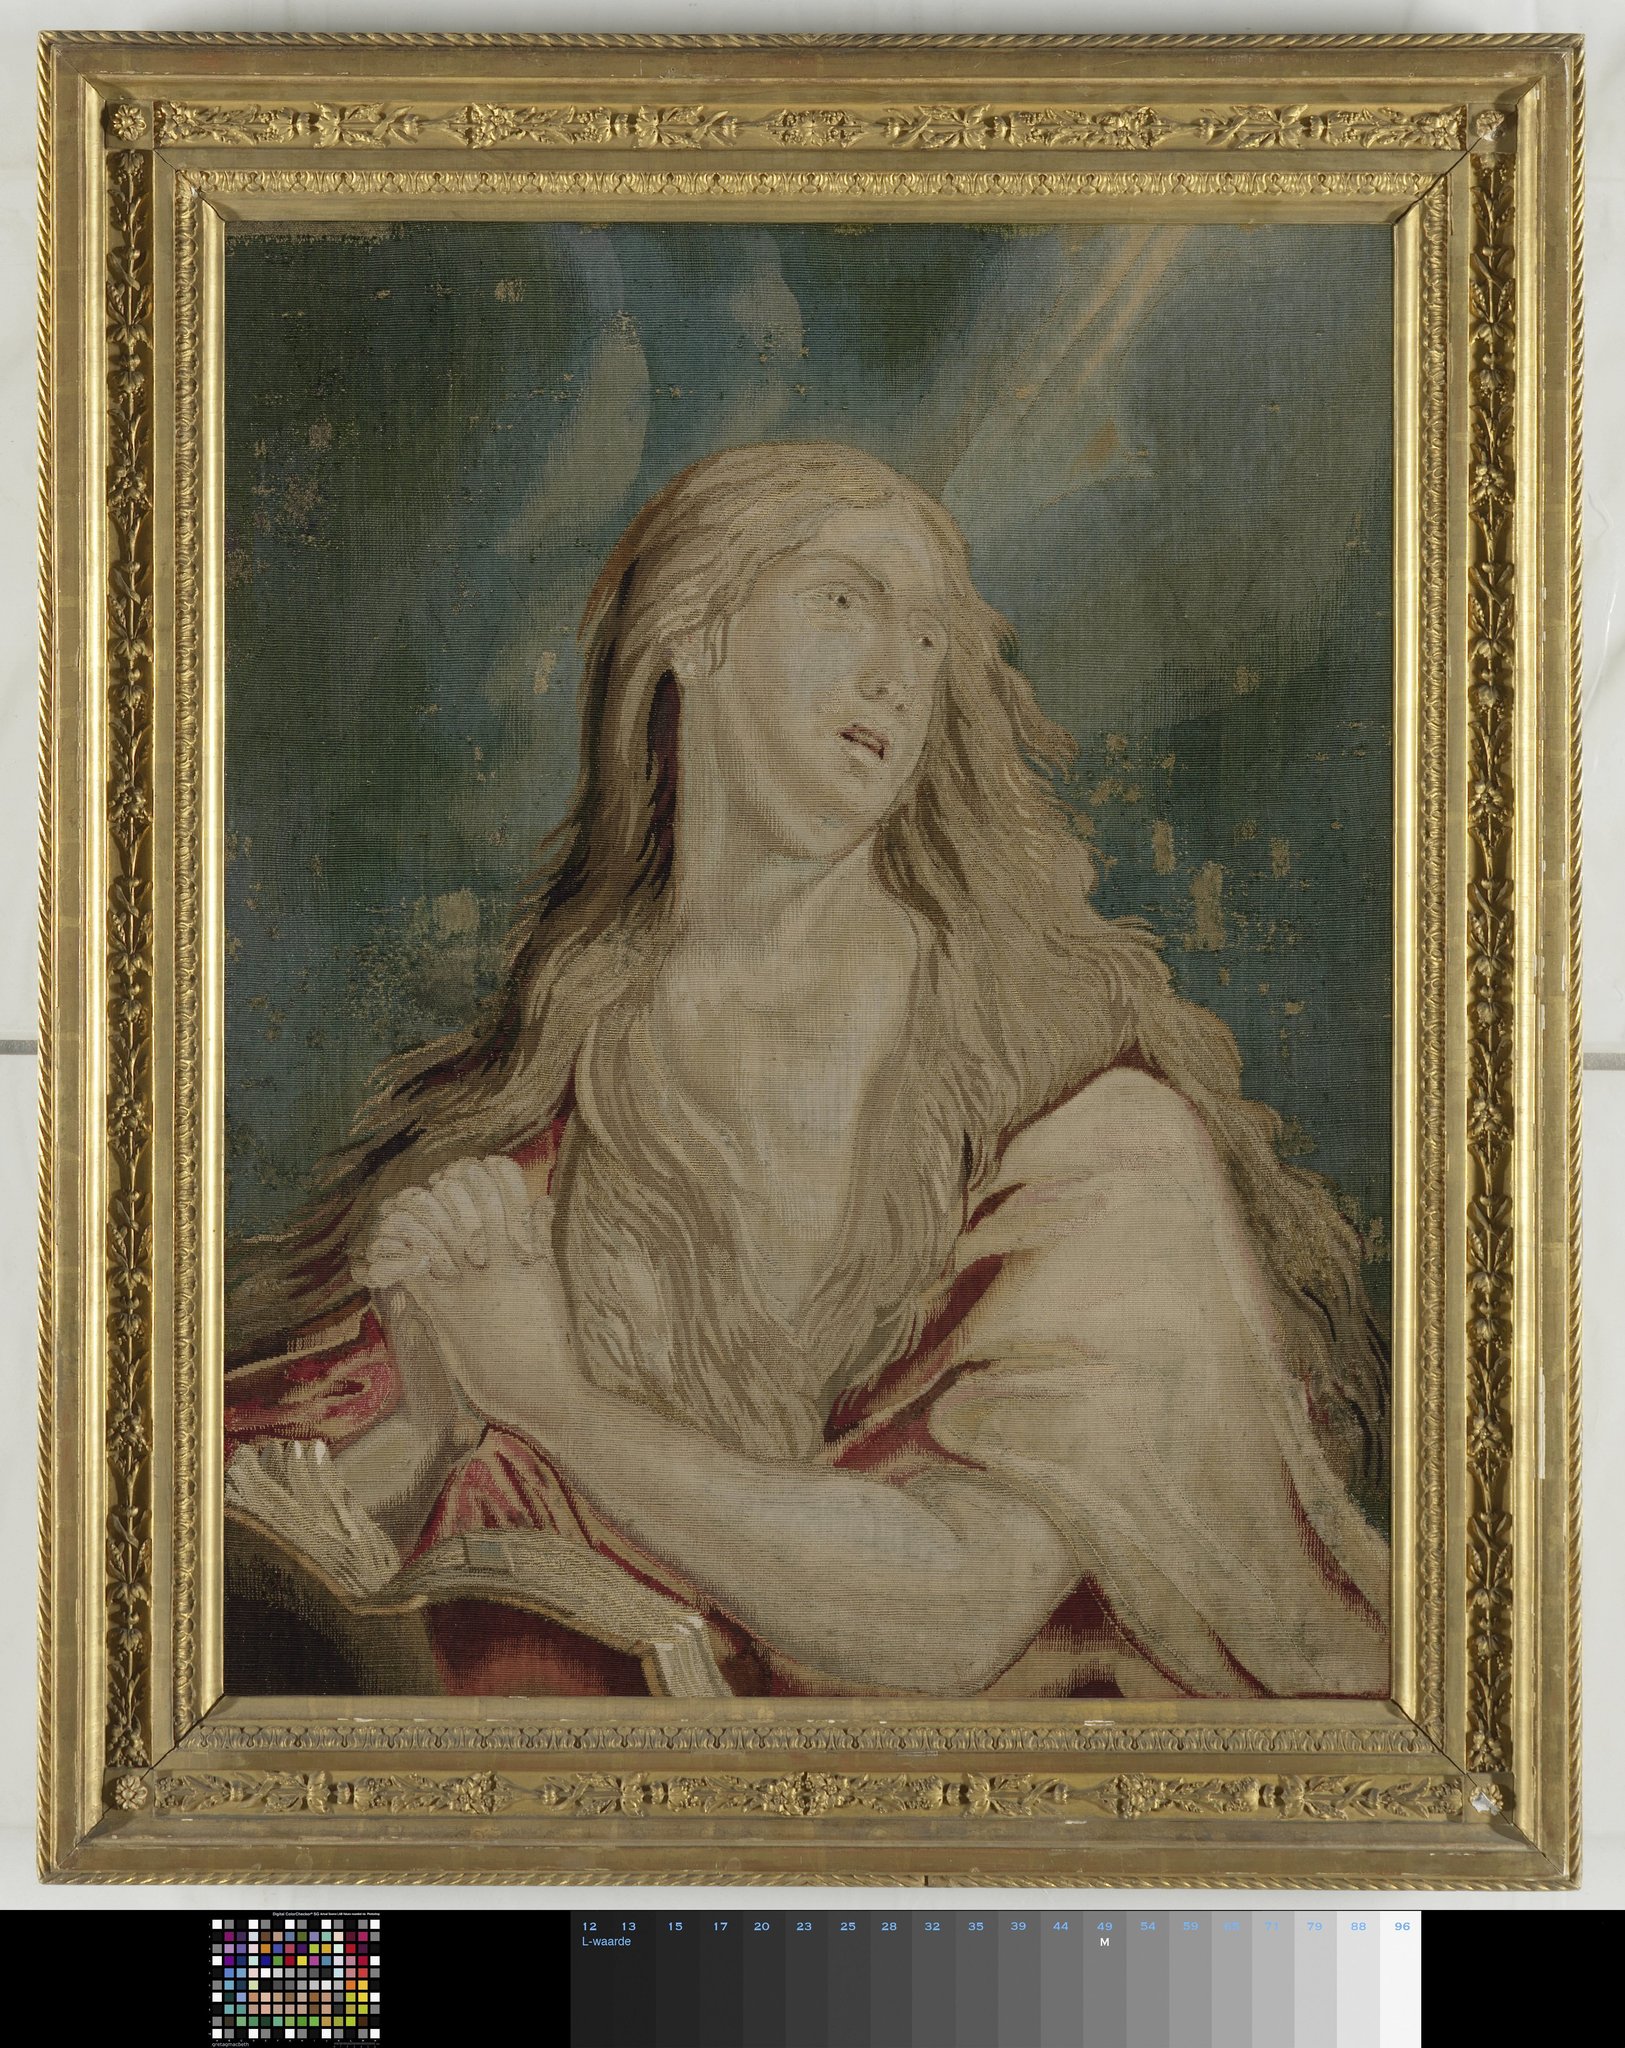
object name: tapestry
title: De berouwvolle Maria Magdalena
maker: guido reni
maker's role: draughtsman, painter, print maker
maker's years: 1575-1642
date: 1750-1790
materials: silk, wood, wool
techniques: tapestry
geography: paris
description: Tapisserie met afbeelding van Maria Magdalena in vergulde lijst.